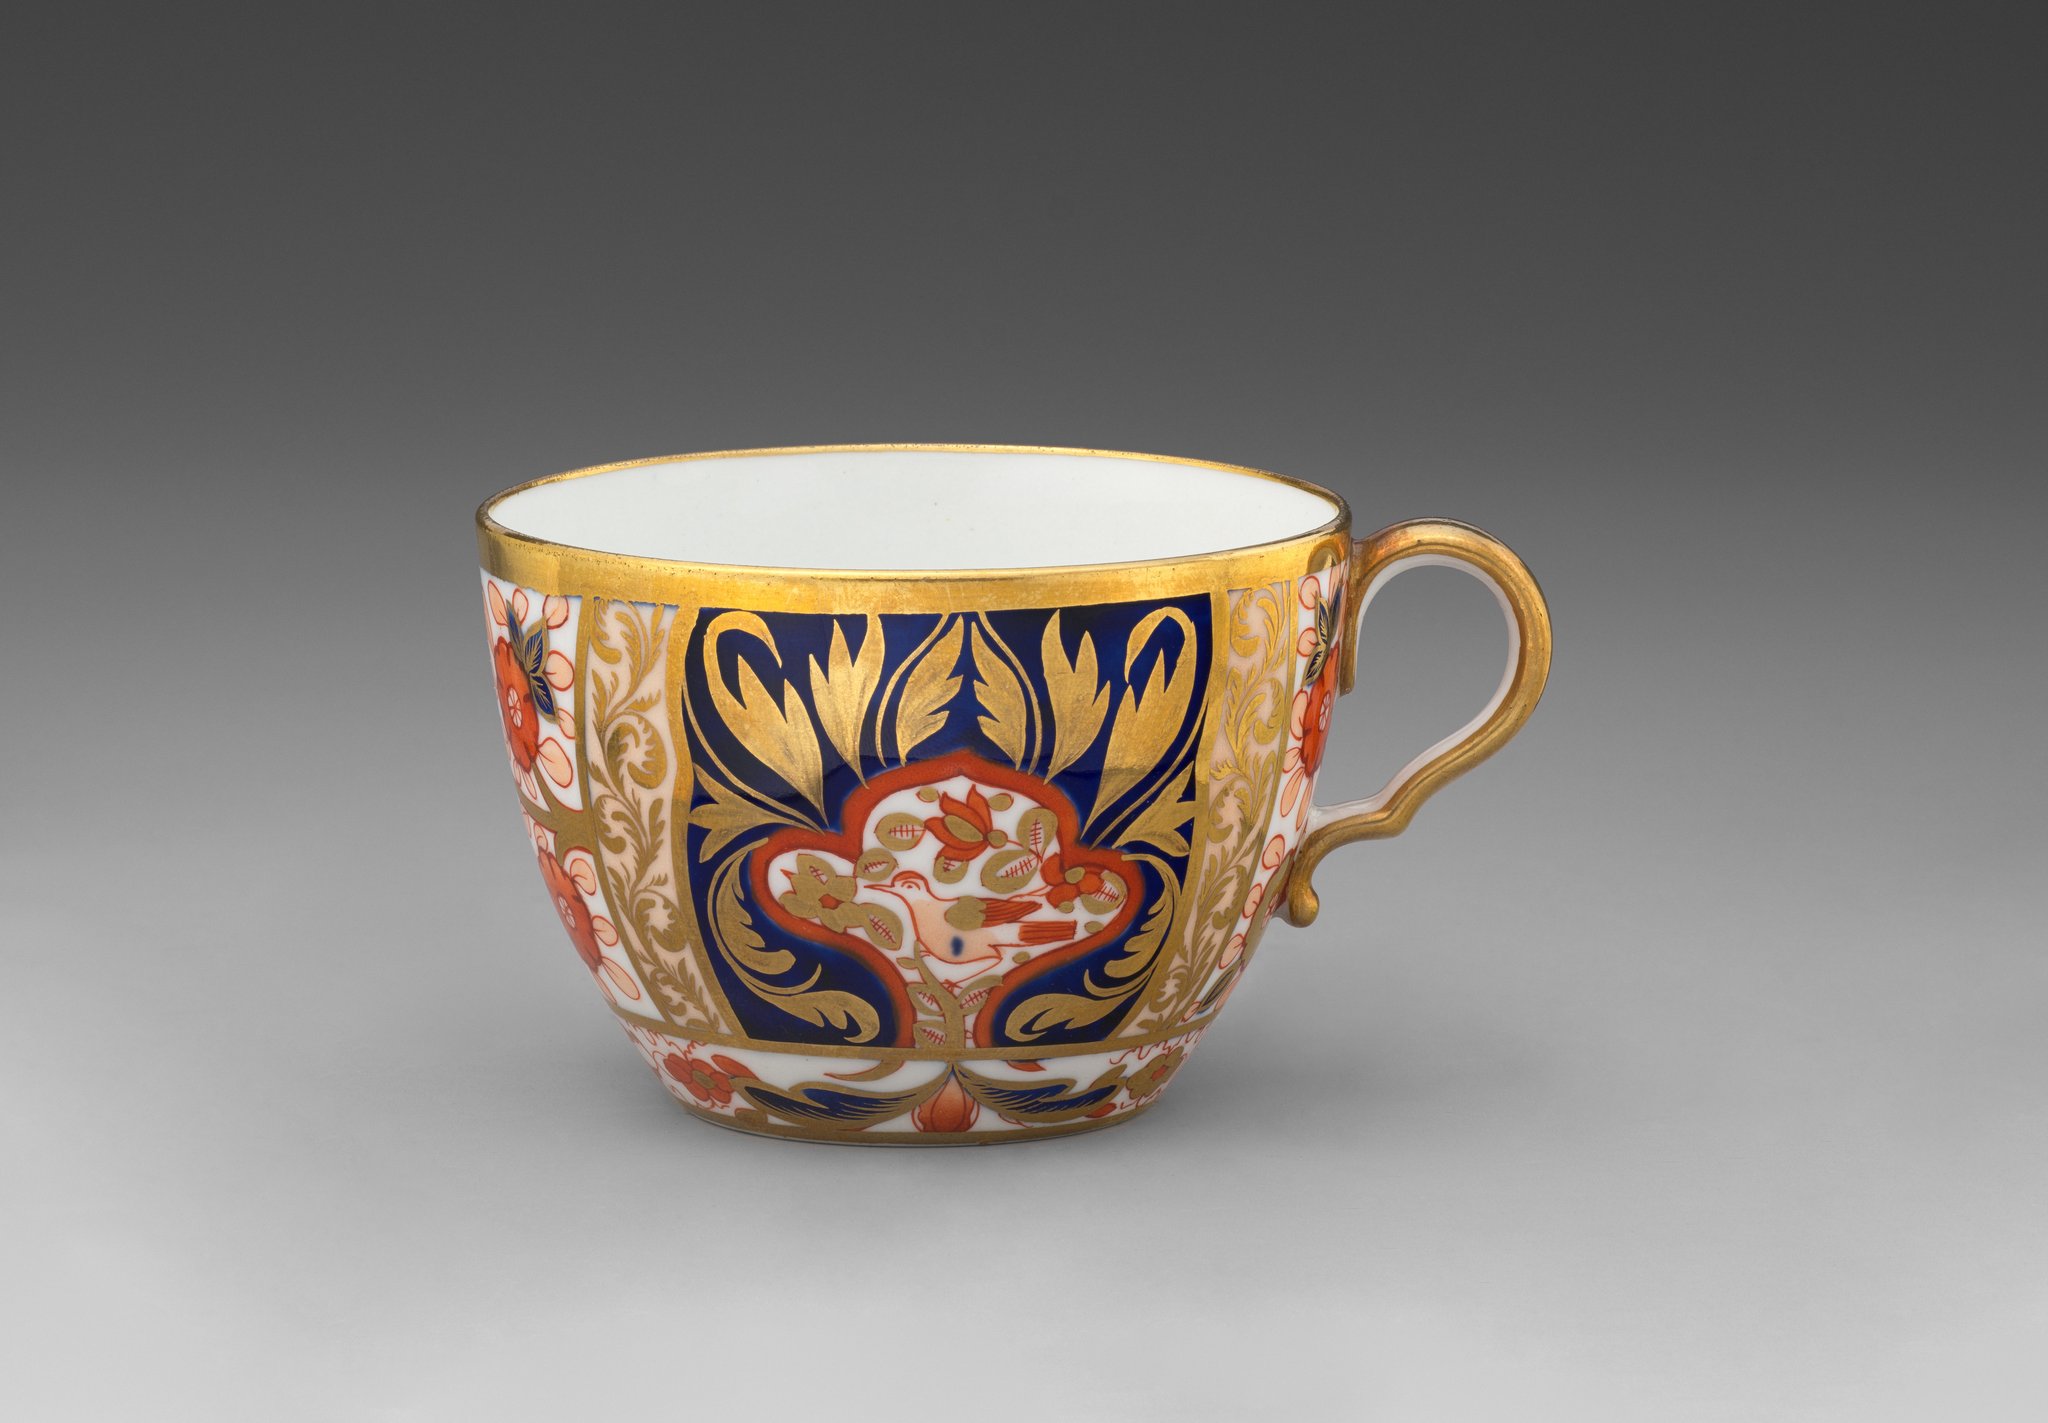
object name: cup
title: Cup (part of a service)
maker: j. spode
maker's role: factory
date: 1800-1830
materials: soft paste porcelain